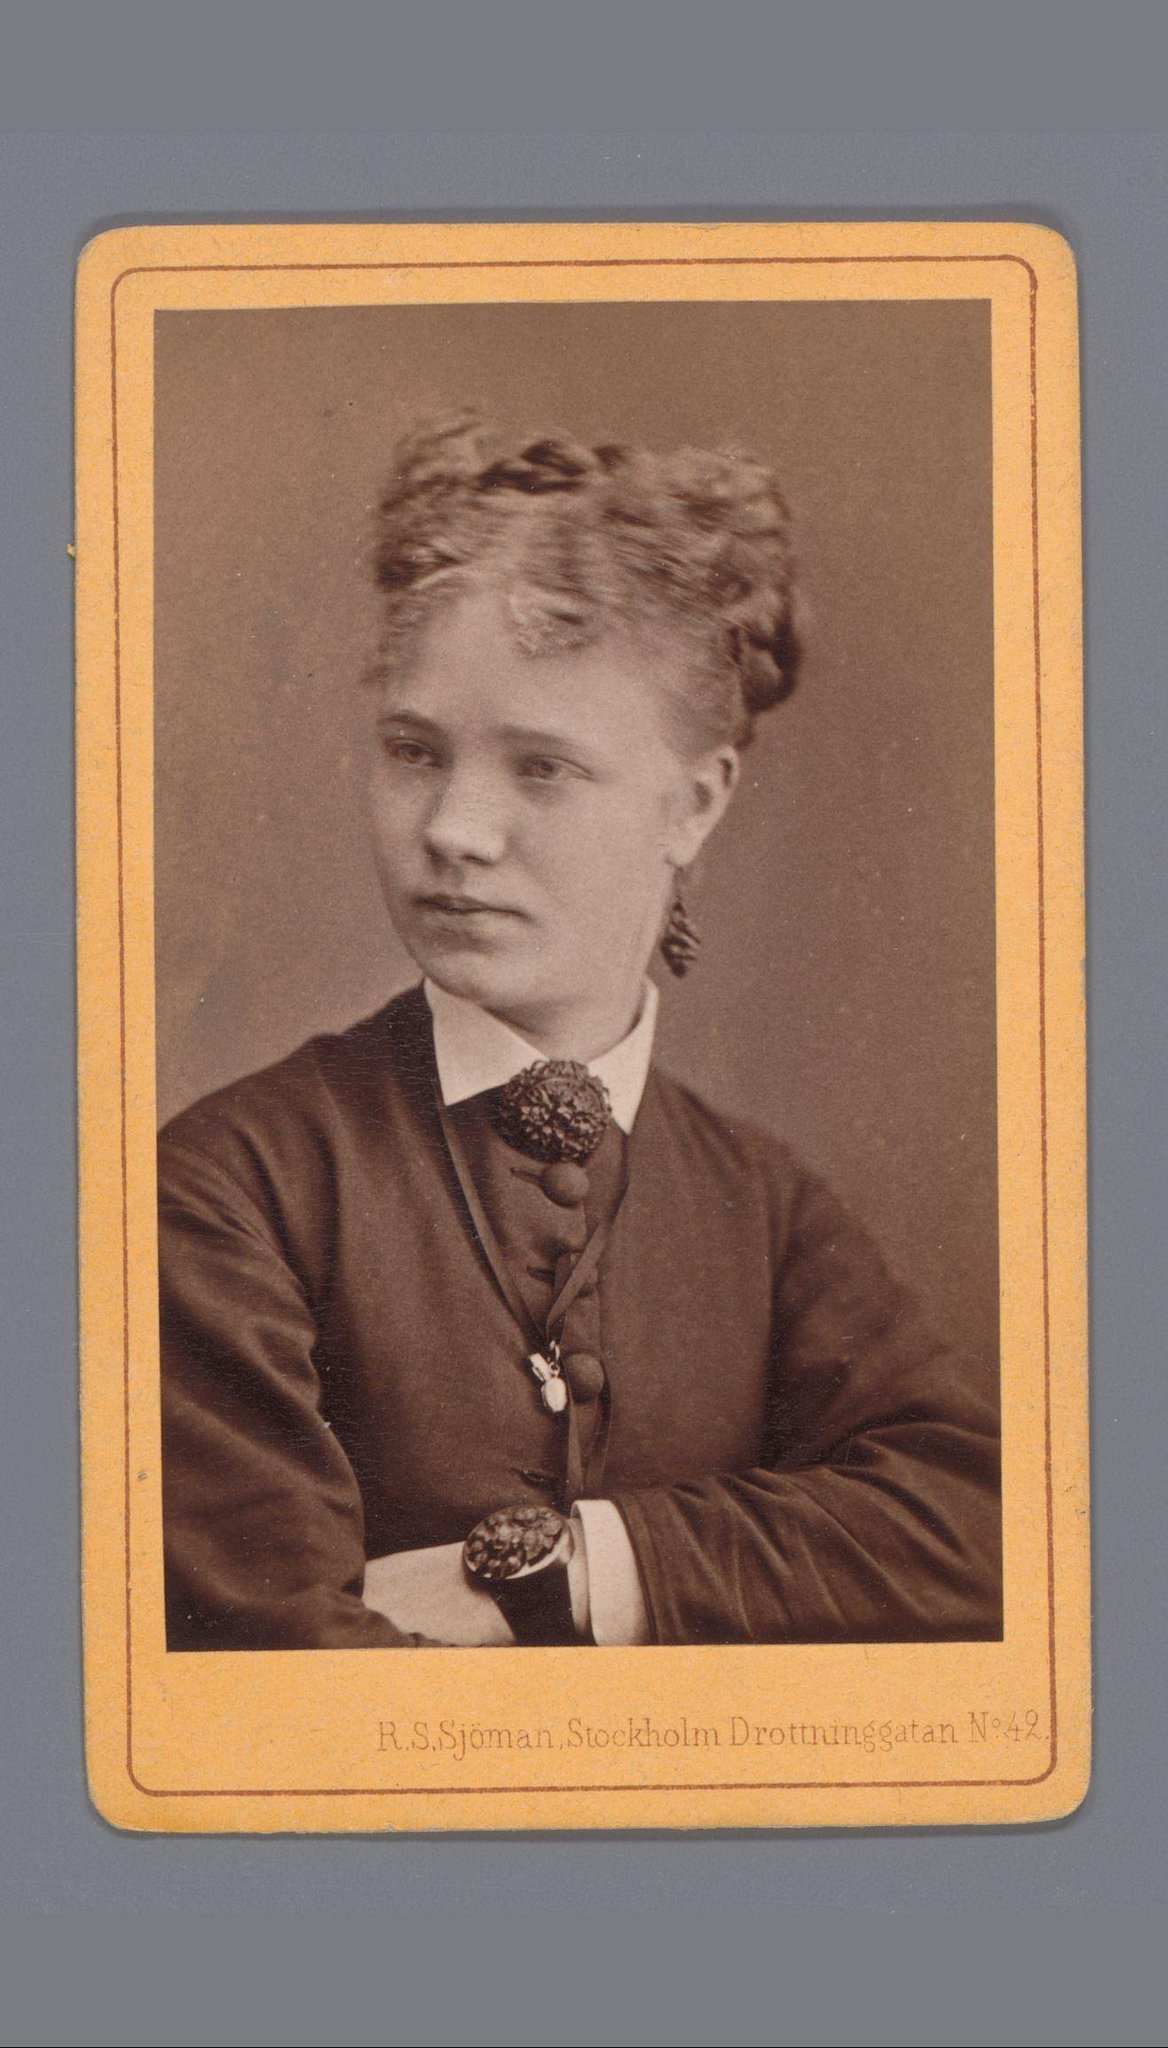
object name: photograph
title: Portret van een onbekende vrouw met de armen over elkaar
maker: rosalie sophie sjöman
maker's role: fotograaf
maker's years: 1833-1919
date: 1864-1882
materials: cardboard, paper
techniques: albumen print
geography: stockholm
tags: historical persons - bb - woman, arms folded over the abdomen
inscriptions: inscription: ‘ATELIER/ för fotografi,/ Rosalie Sjöman/ STOCKHOLM/ No. 42, Drottninggatan No. 42./ öfver gården 2 tr. upp./ Plåten förvaras för efterbeställning.’